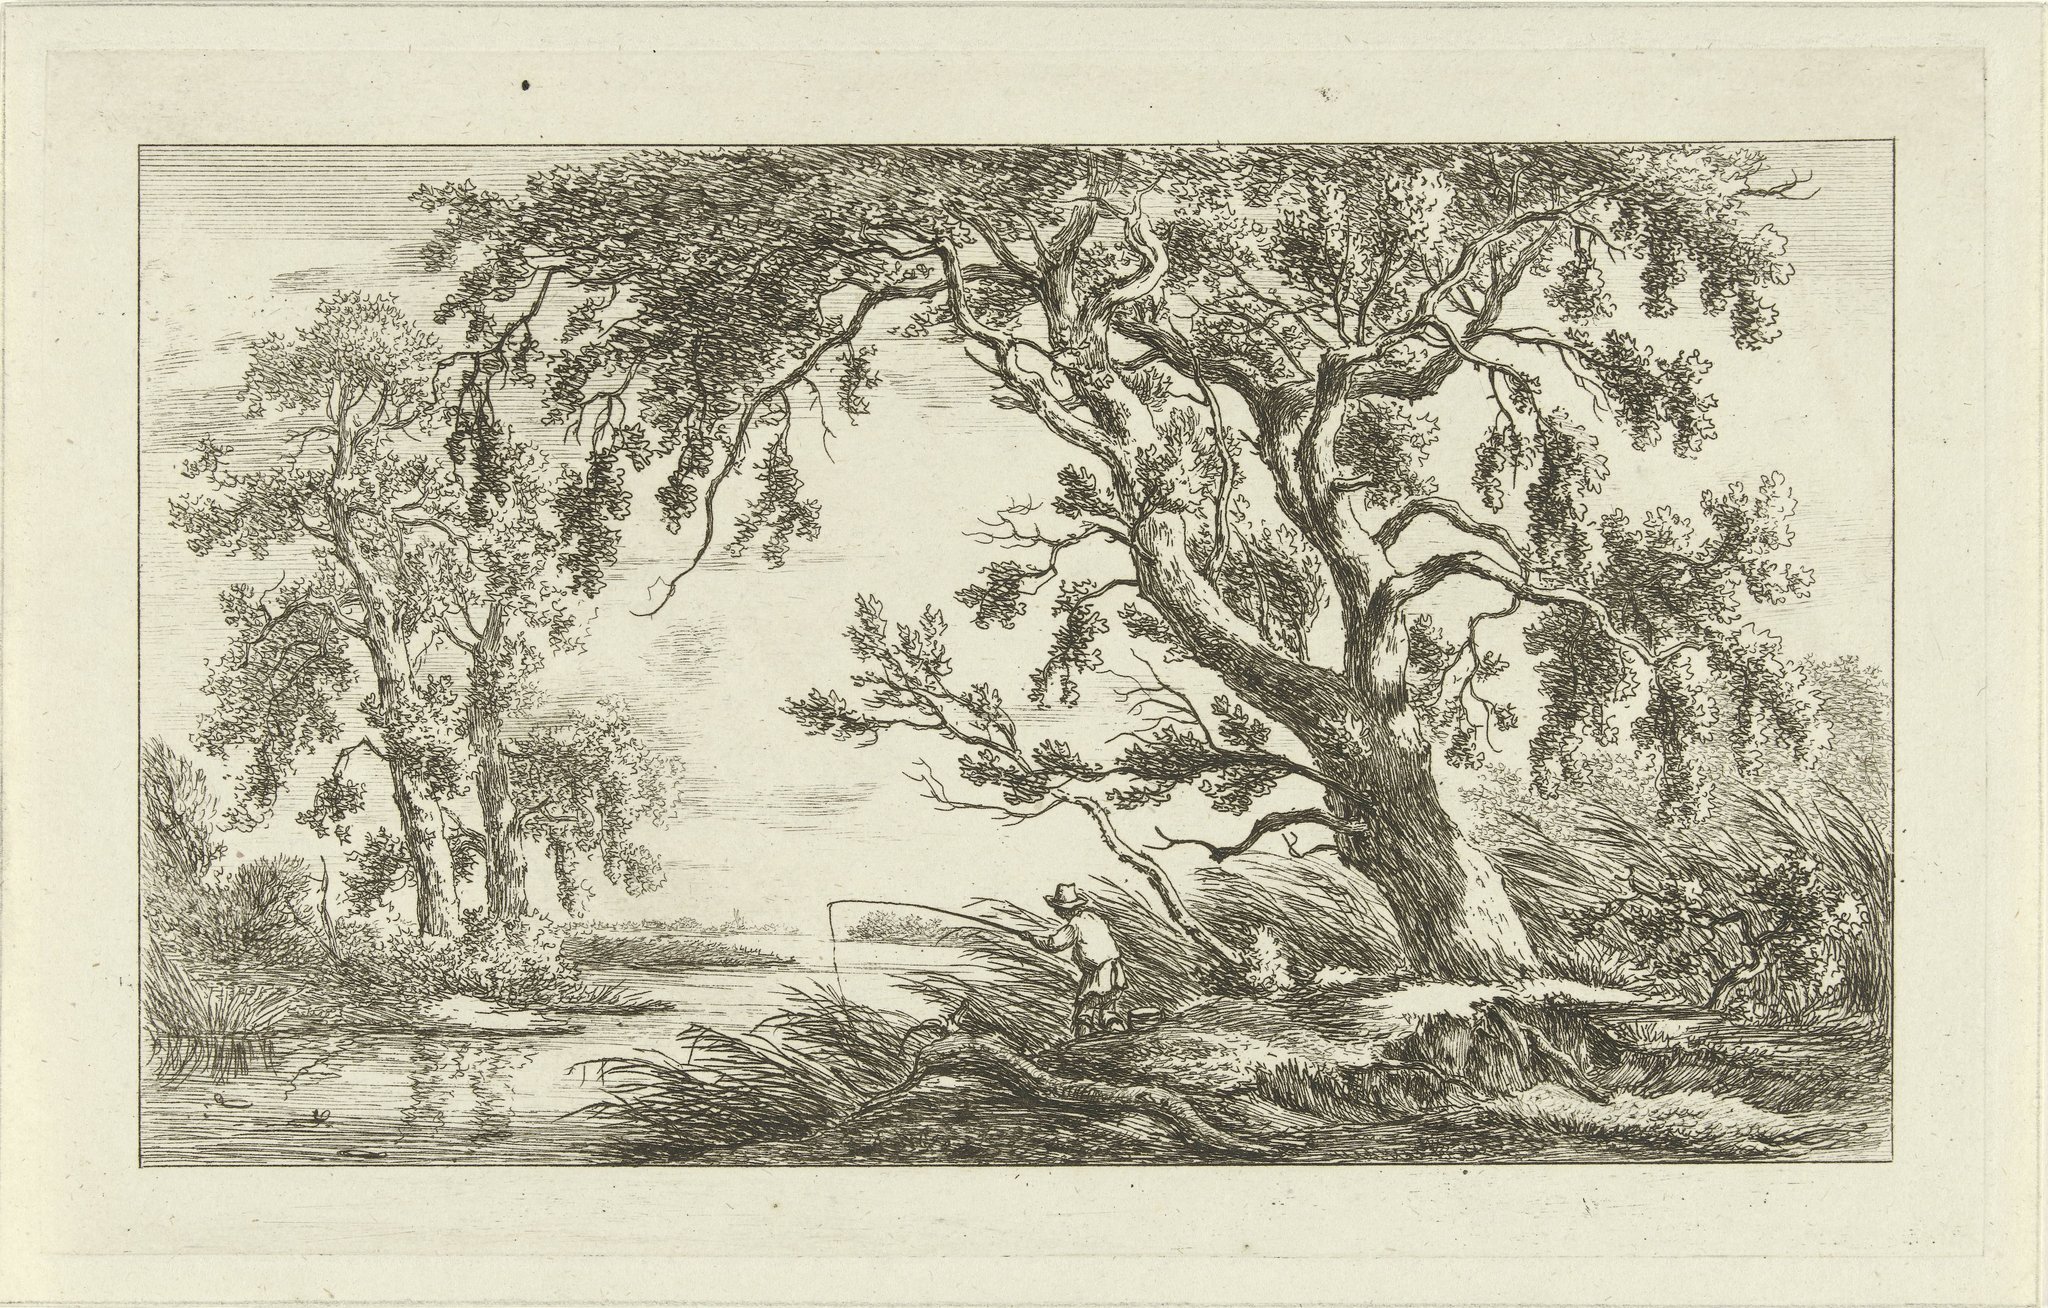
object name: print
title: Landschappen (a-f)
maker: carel lodewijk hansen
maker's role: draughtsman, painter, print maker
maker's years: 1765-1840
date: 1780-1840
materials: paper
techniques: etching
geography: netherlands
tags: river, landscapes (+ landscape with figures, staffage), angling, fisherman, haarlem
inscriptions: collector's mark: Lugt 2228